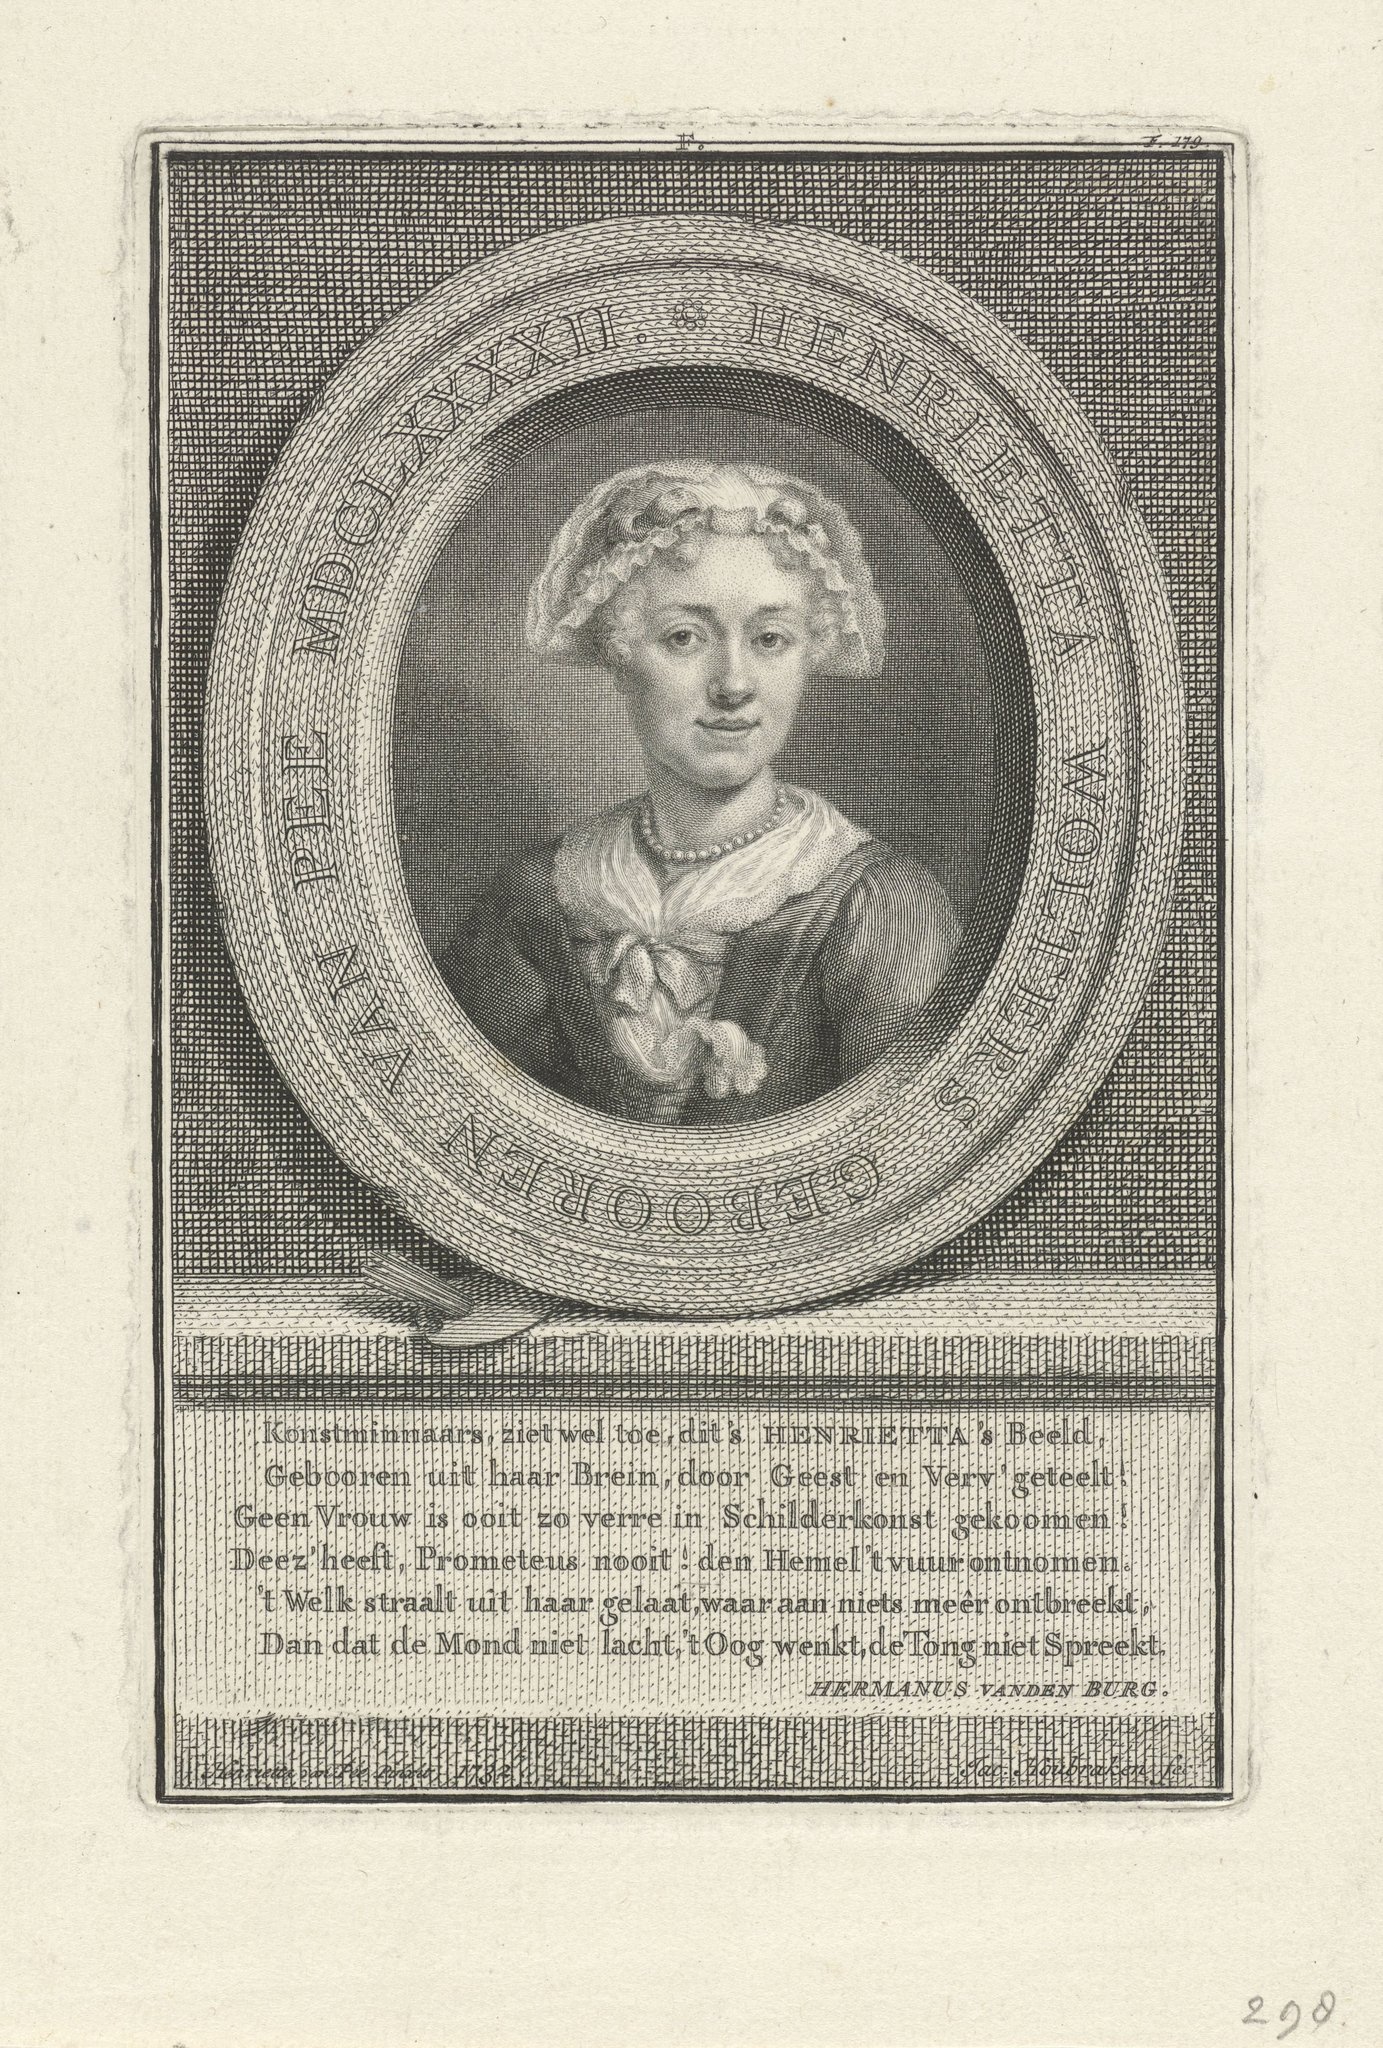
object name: print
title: Portret van Henriëtte Wolters-van Pee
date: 1732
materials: paper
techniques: engraving, etching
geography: amsterdam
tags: amsterdam, haarlem, henriëtte wolters-van pee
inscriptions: collector's mark: Lugt 240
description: Portret van de miniatuurschilderes Henriëtte Wolters-van Pee, met een zesregelig gedicht.